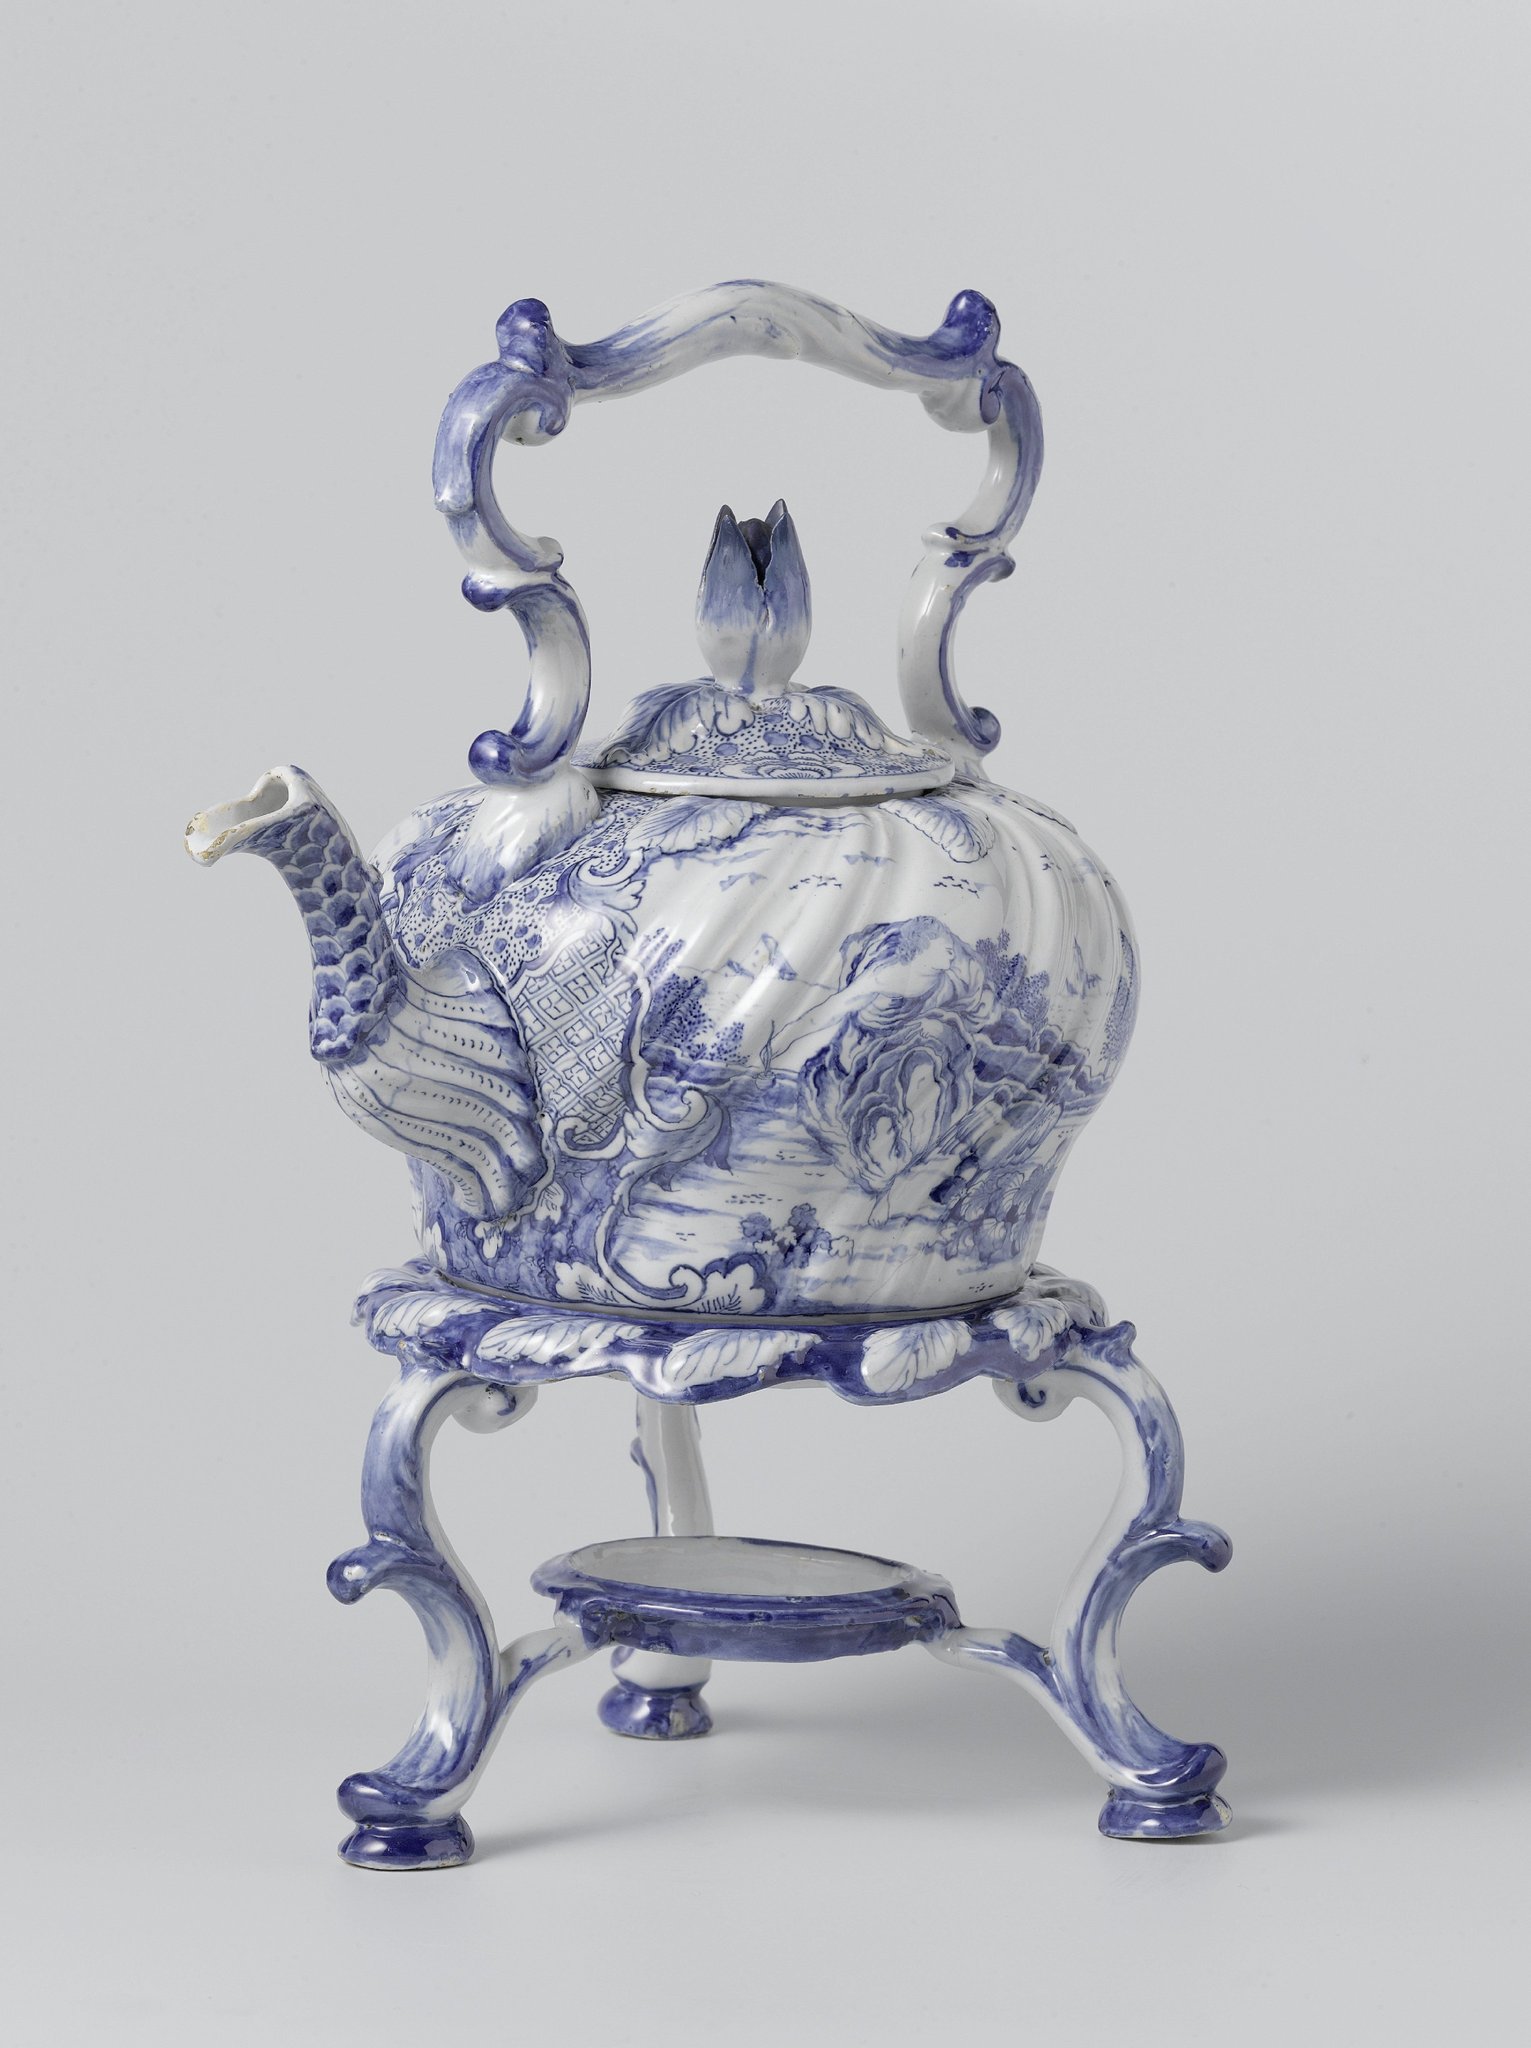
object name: kettle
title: Kettle on a burner stand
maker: geertruij verstelle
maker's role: plateelbakker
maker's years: 1717-1773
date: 1765-1770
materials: earthenware, glaze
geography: delft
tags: john (writing) on the island of patmos, possibly the eagle beside him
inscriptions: mark: ‘G.V.S.’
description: Ketel van faience. De ketel staat op een bijbehorend komfoor (BK-1955-65-b).